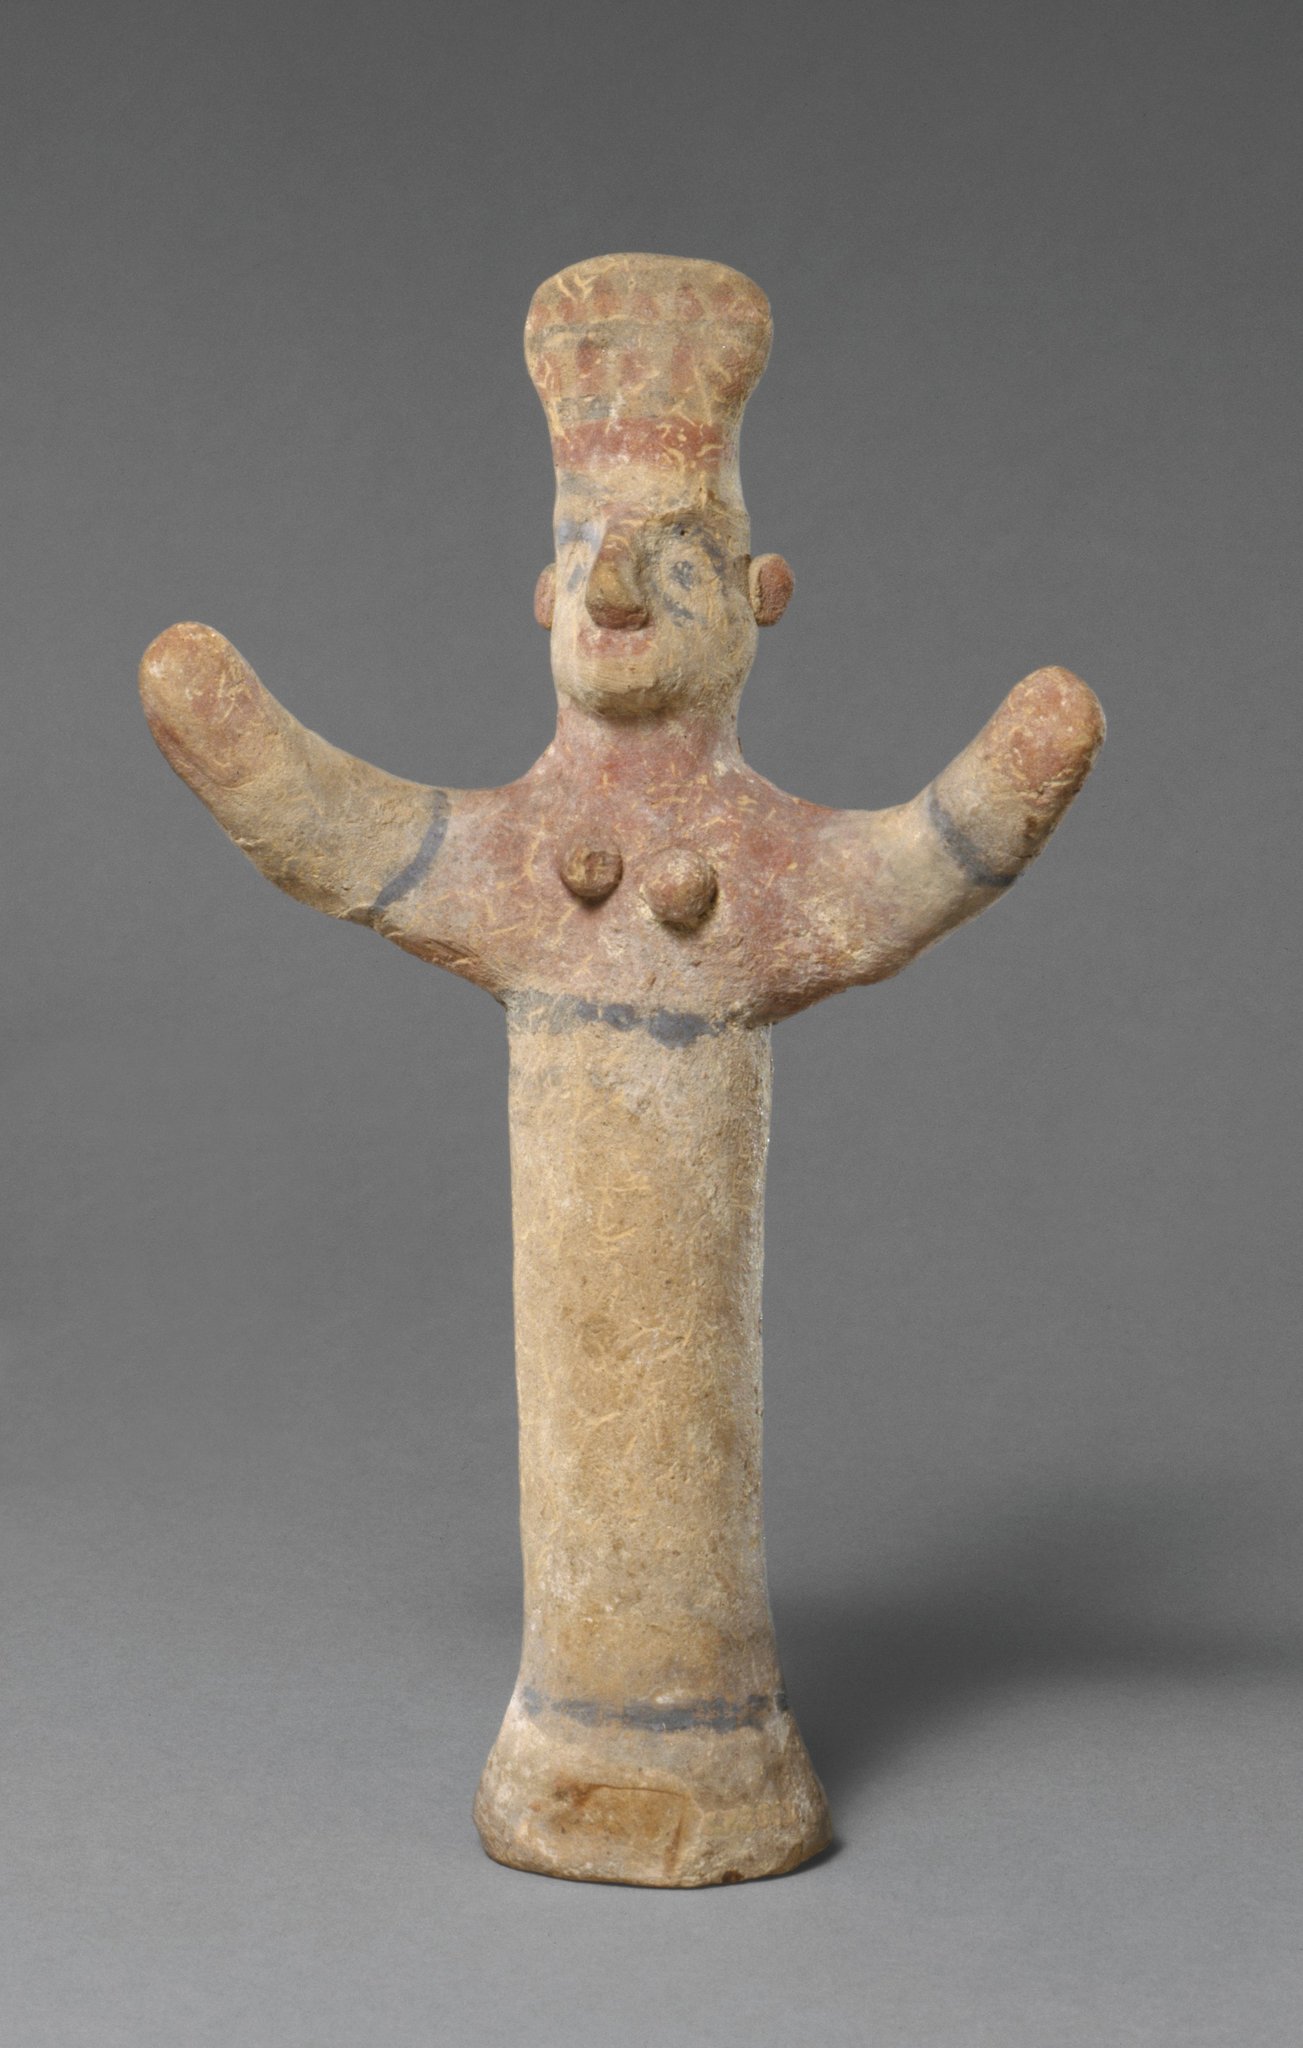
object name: statuette of a woman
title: Standing female figurine of the "goddess with uplifted arms" type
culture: cypriot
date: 600-480 BCE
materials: terracotta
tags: women